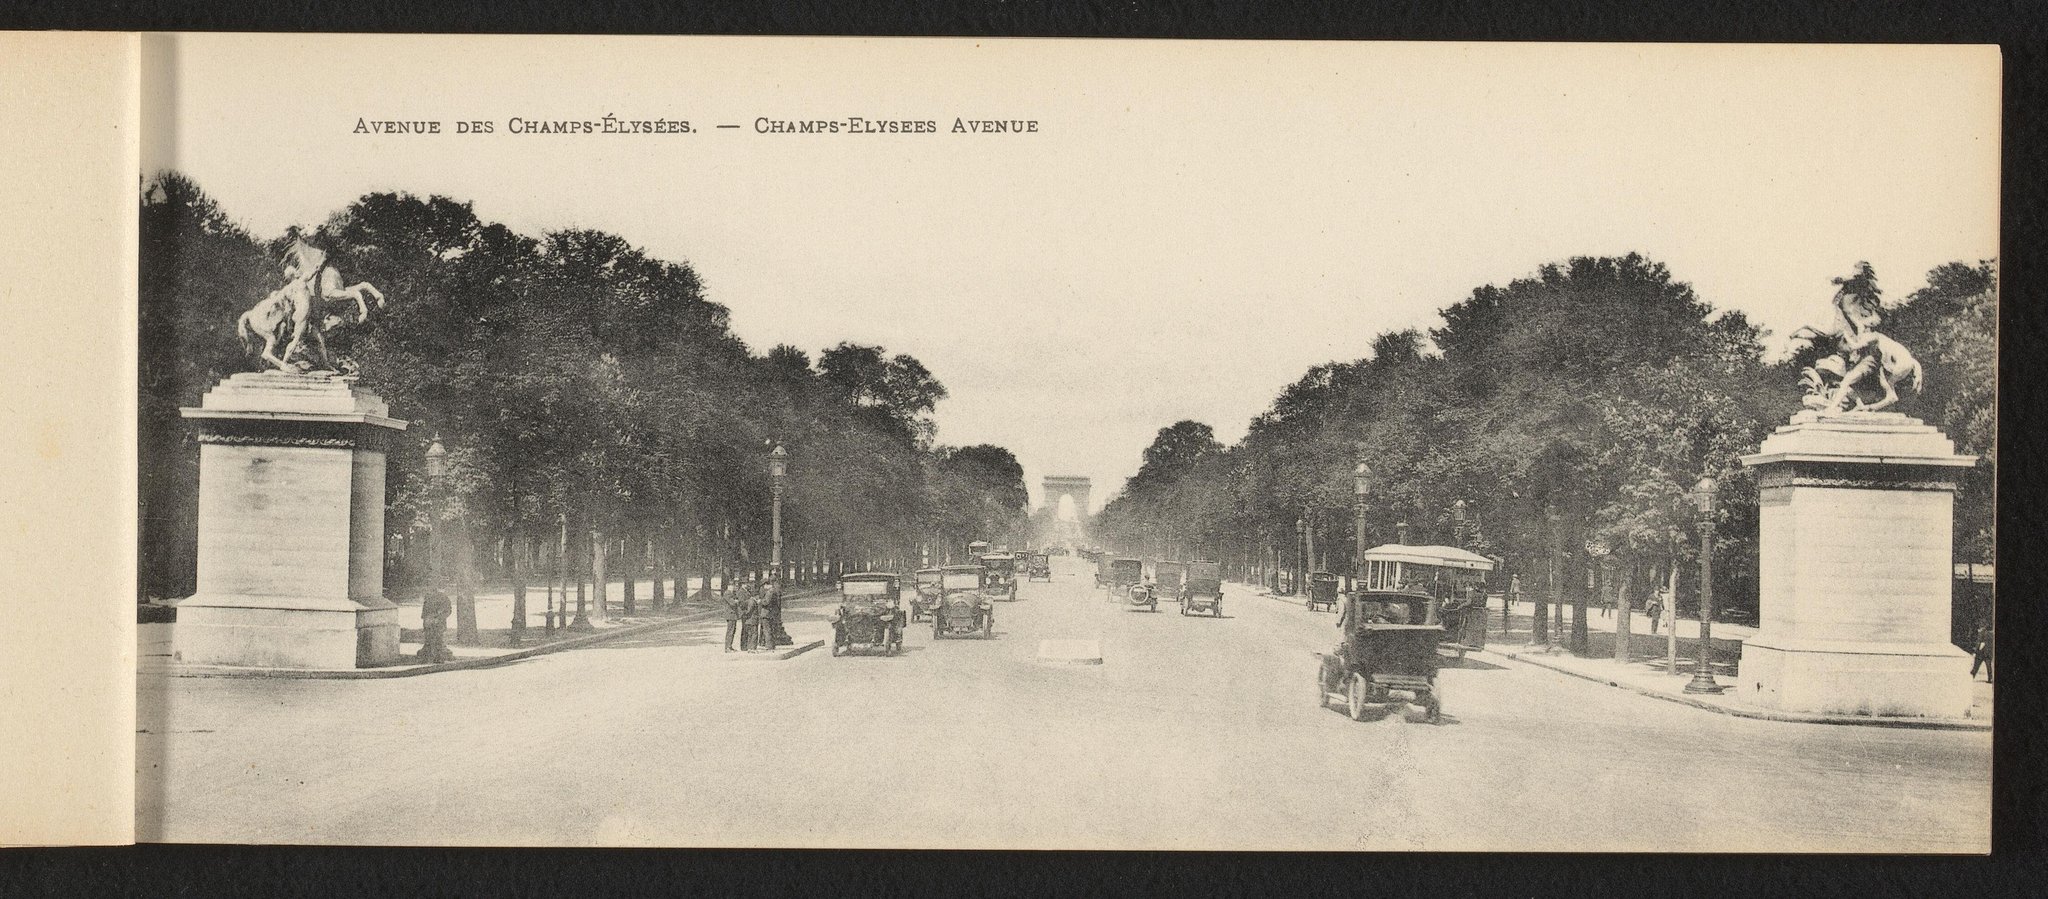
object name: photomechanical print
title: Avenue des Champs-Élysées / Champs-Elysees Avenue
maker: Anonymous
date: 1920-1932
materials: cardboard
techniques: photograph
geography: paris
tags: avenue, boulevard, promenade, esplanade (+ city(-scape) with figures, staffage), triumphal arch